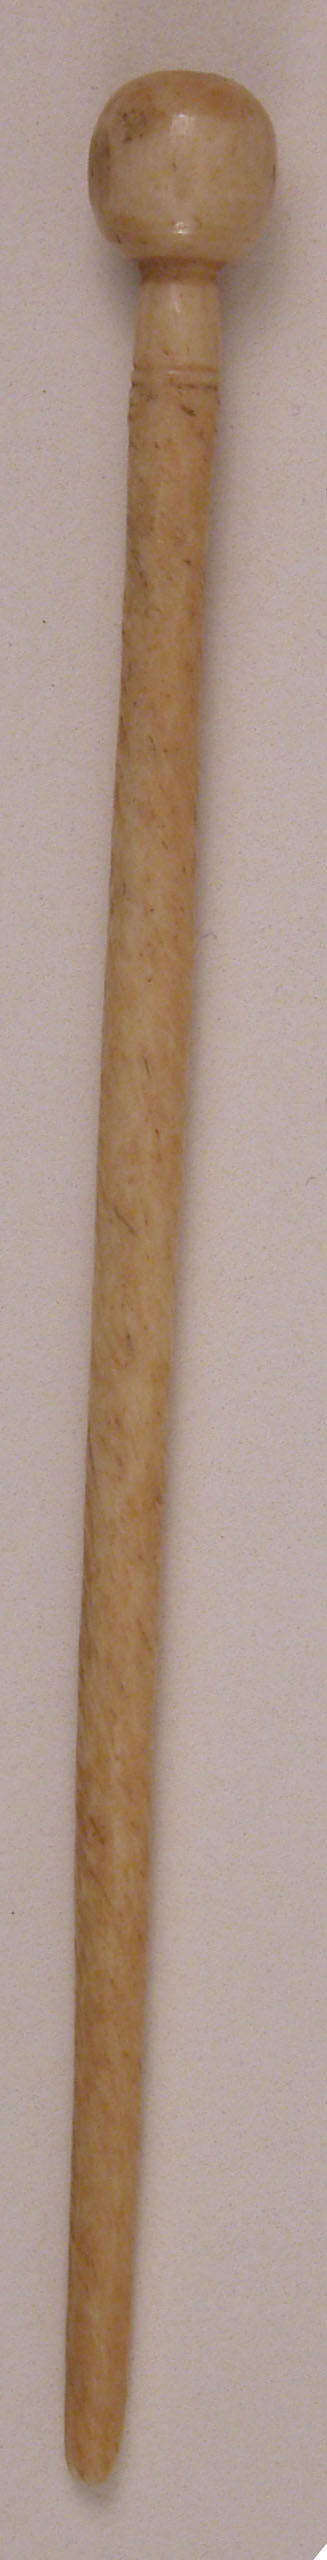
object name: pin or stylus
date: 401-800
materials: bone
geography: palestine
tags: pins